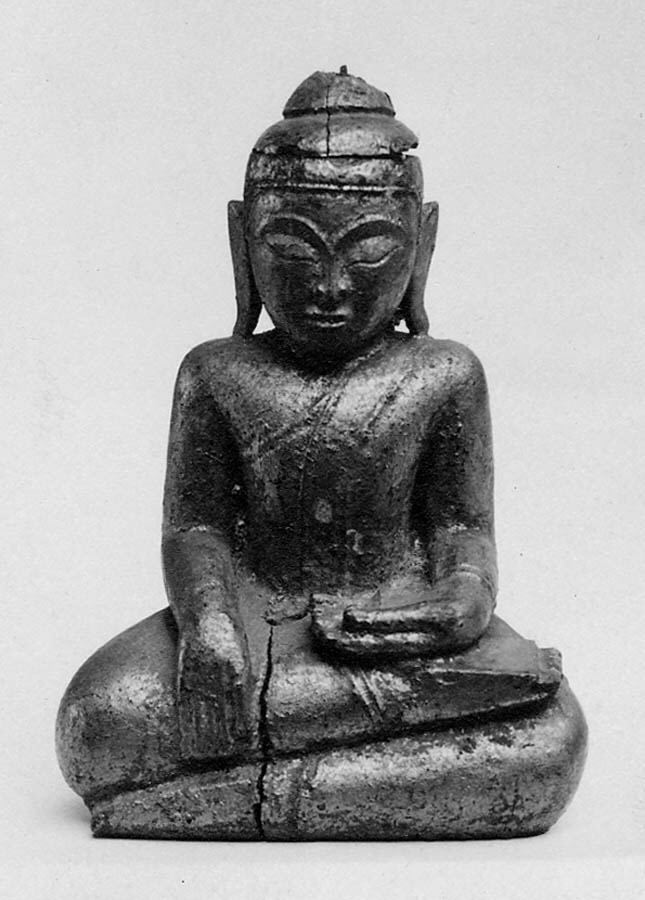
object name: statuette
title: Seated Buddha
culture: cambodian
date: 1801-1900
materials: gilt, wood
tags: buddhism,buddha